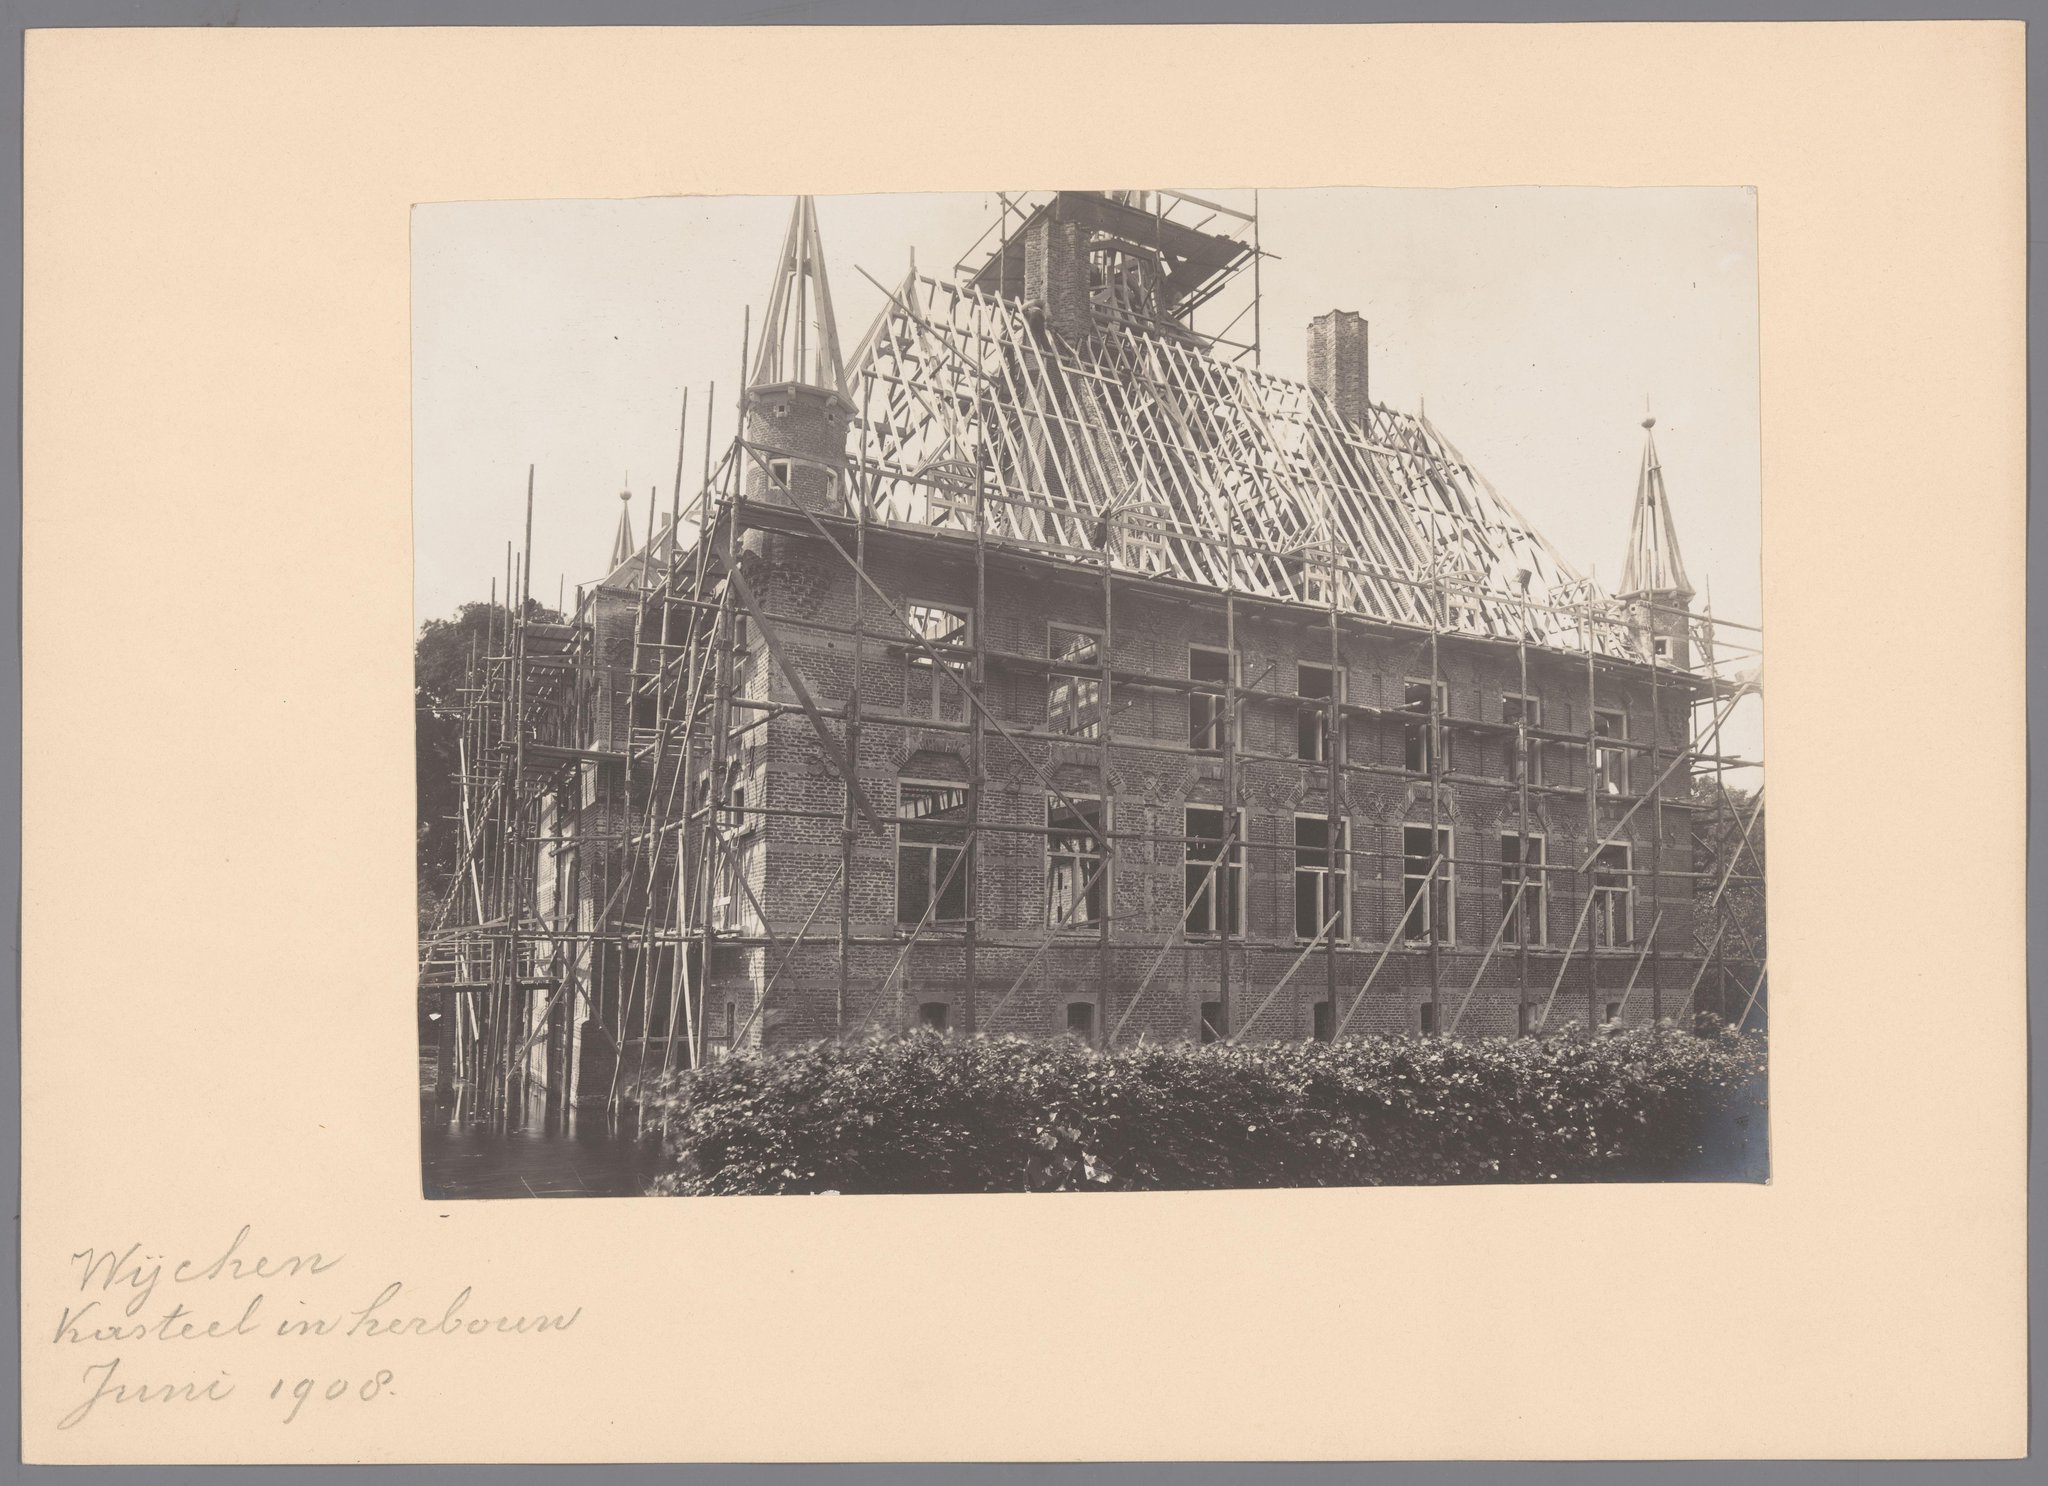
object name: photograph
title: Herbouw van het Kasteel van Wijchen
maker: anoniem (monumentenzorg)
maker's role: fotograaf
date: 1908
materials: cardboard, photographic support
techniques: gelatin silver print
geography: wijchen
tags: castle, landscape with tower or castle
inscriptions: annotation: ‘Wijchen/ Kasteel in herbouw/ Juni 1908’